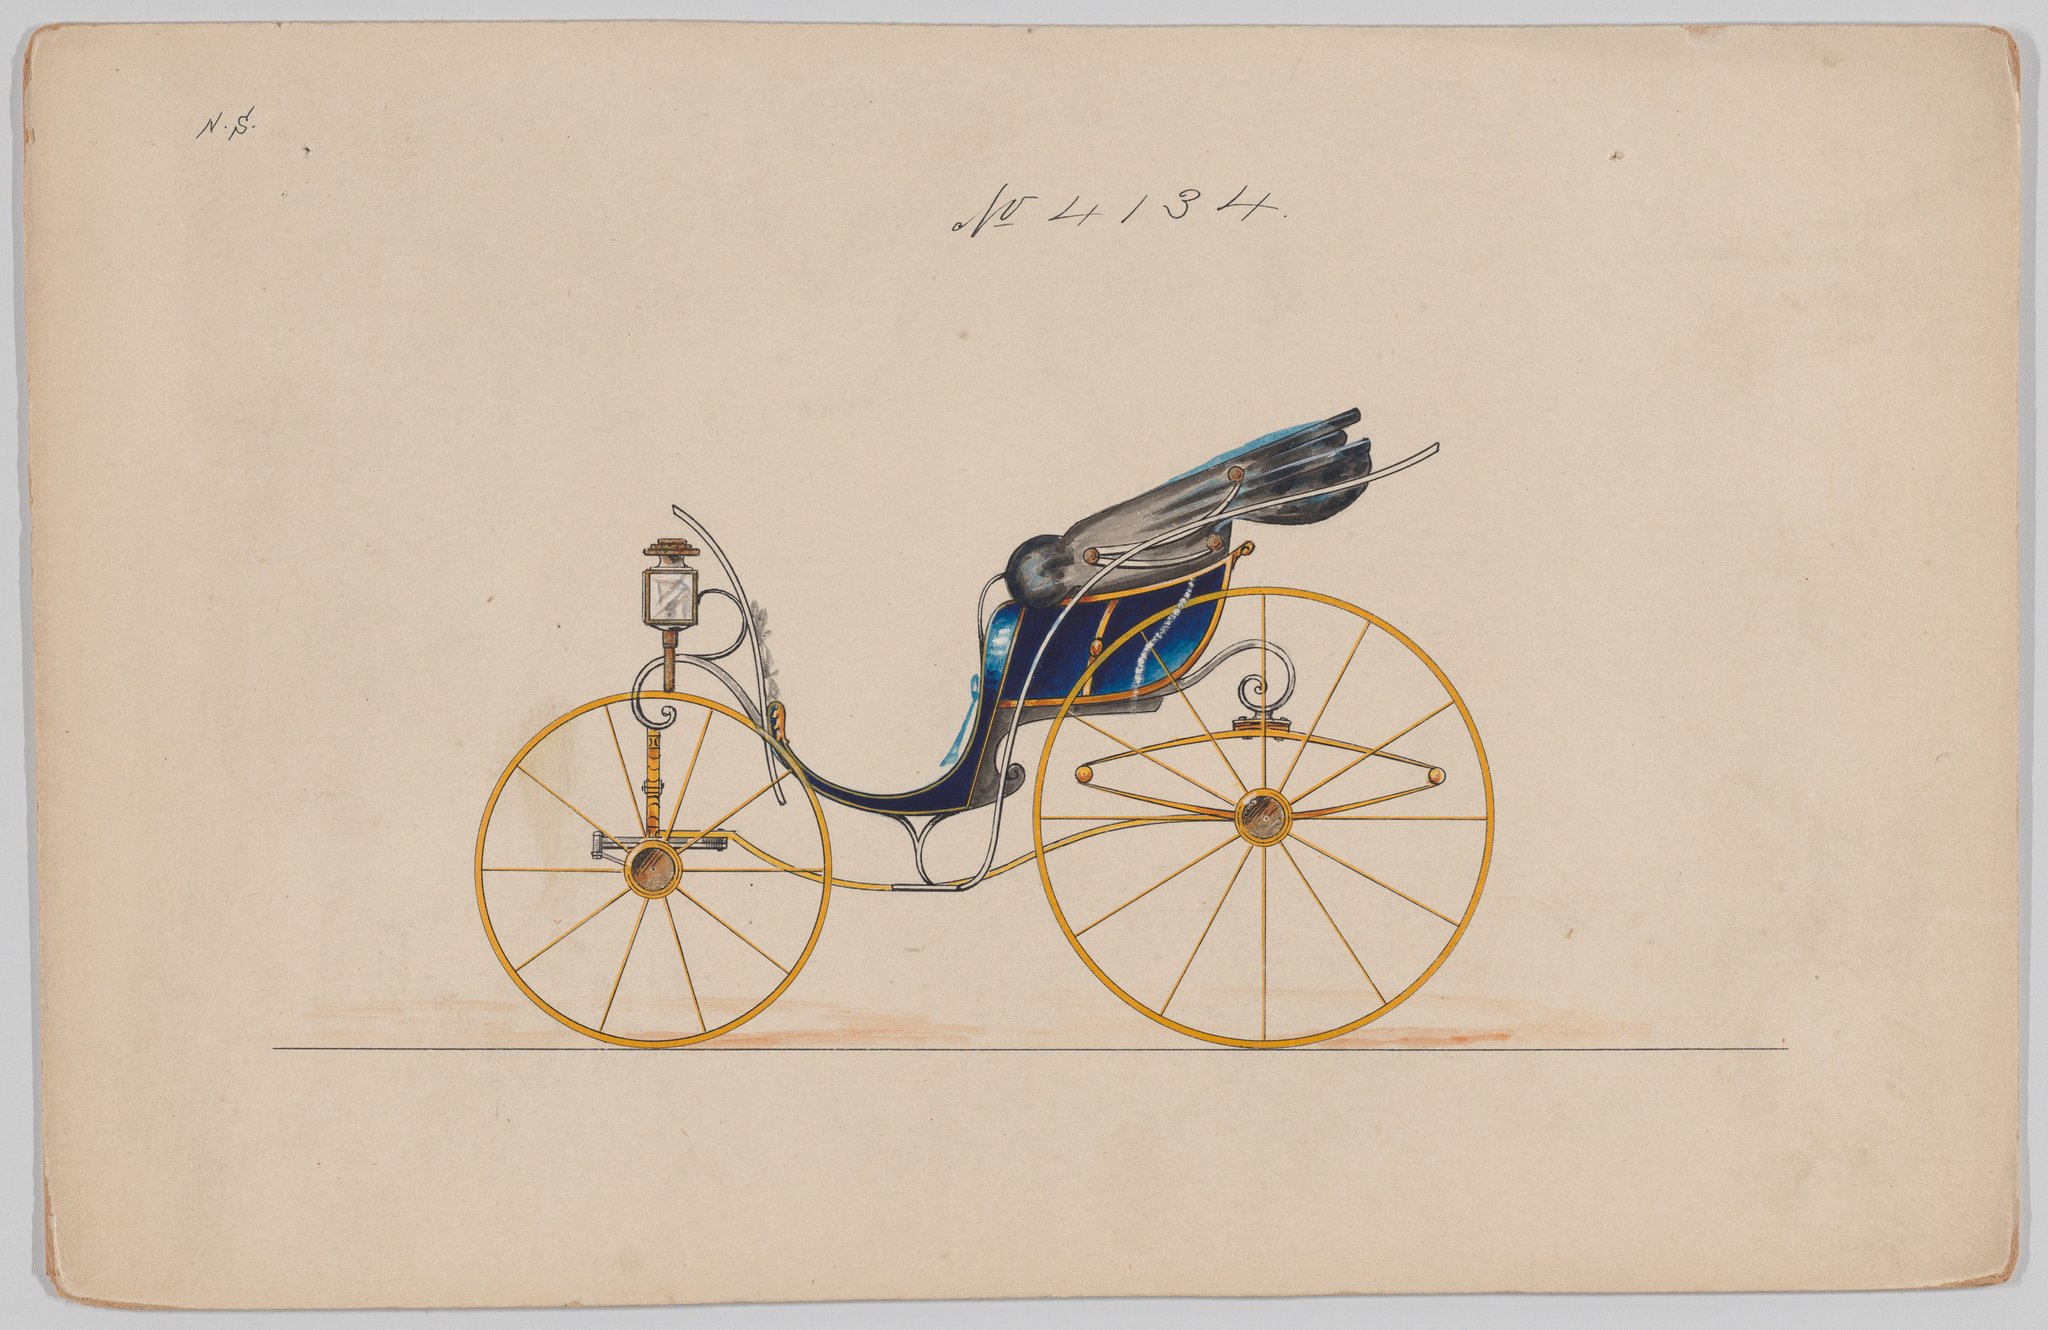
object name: drawing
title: Design for Pony Phaeton, no. 4134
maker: brewster & co.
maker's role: manufacturer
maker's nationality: american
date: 1891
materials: gouache, graphite, ink, watercolor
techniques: pen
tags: carriages